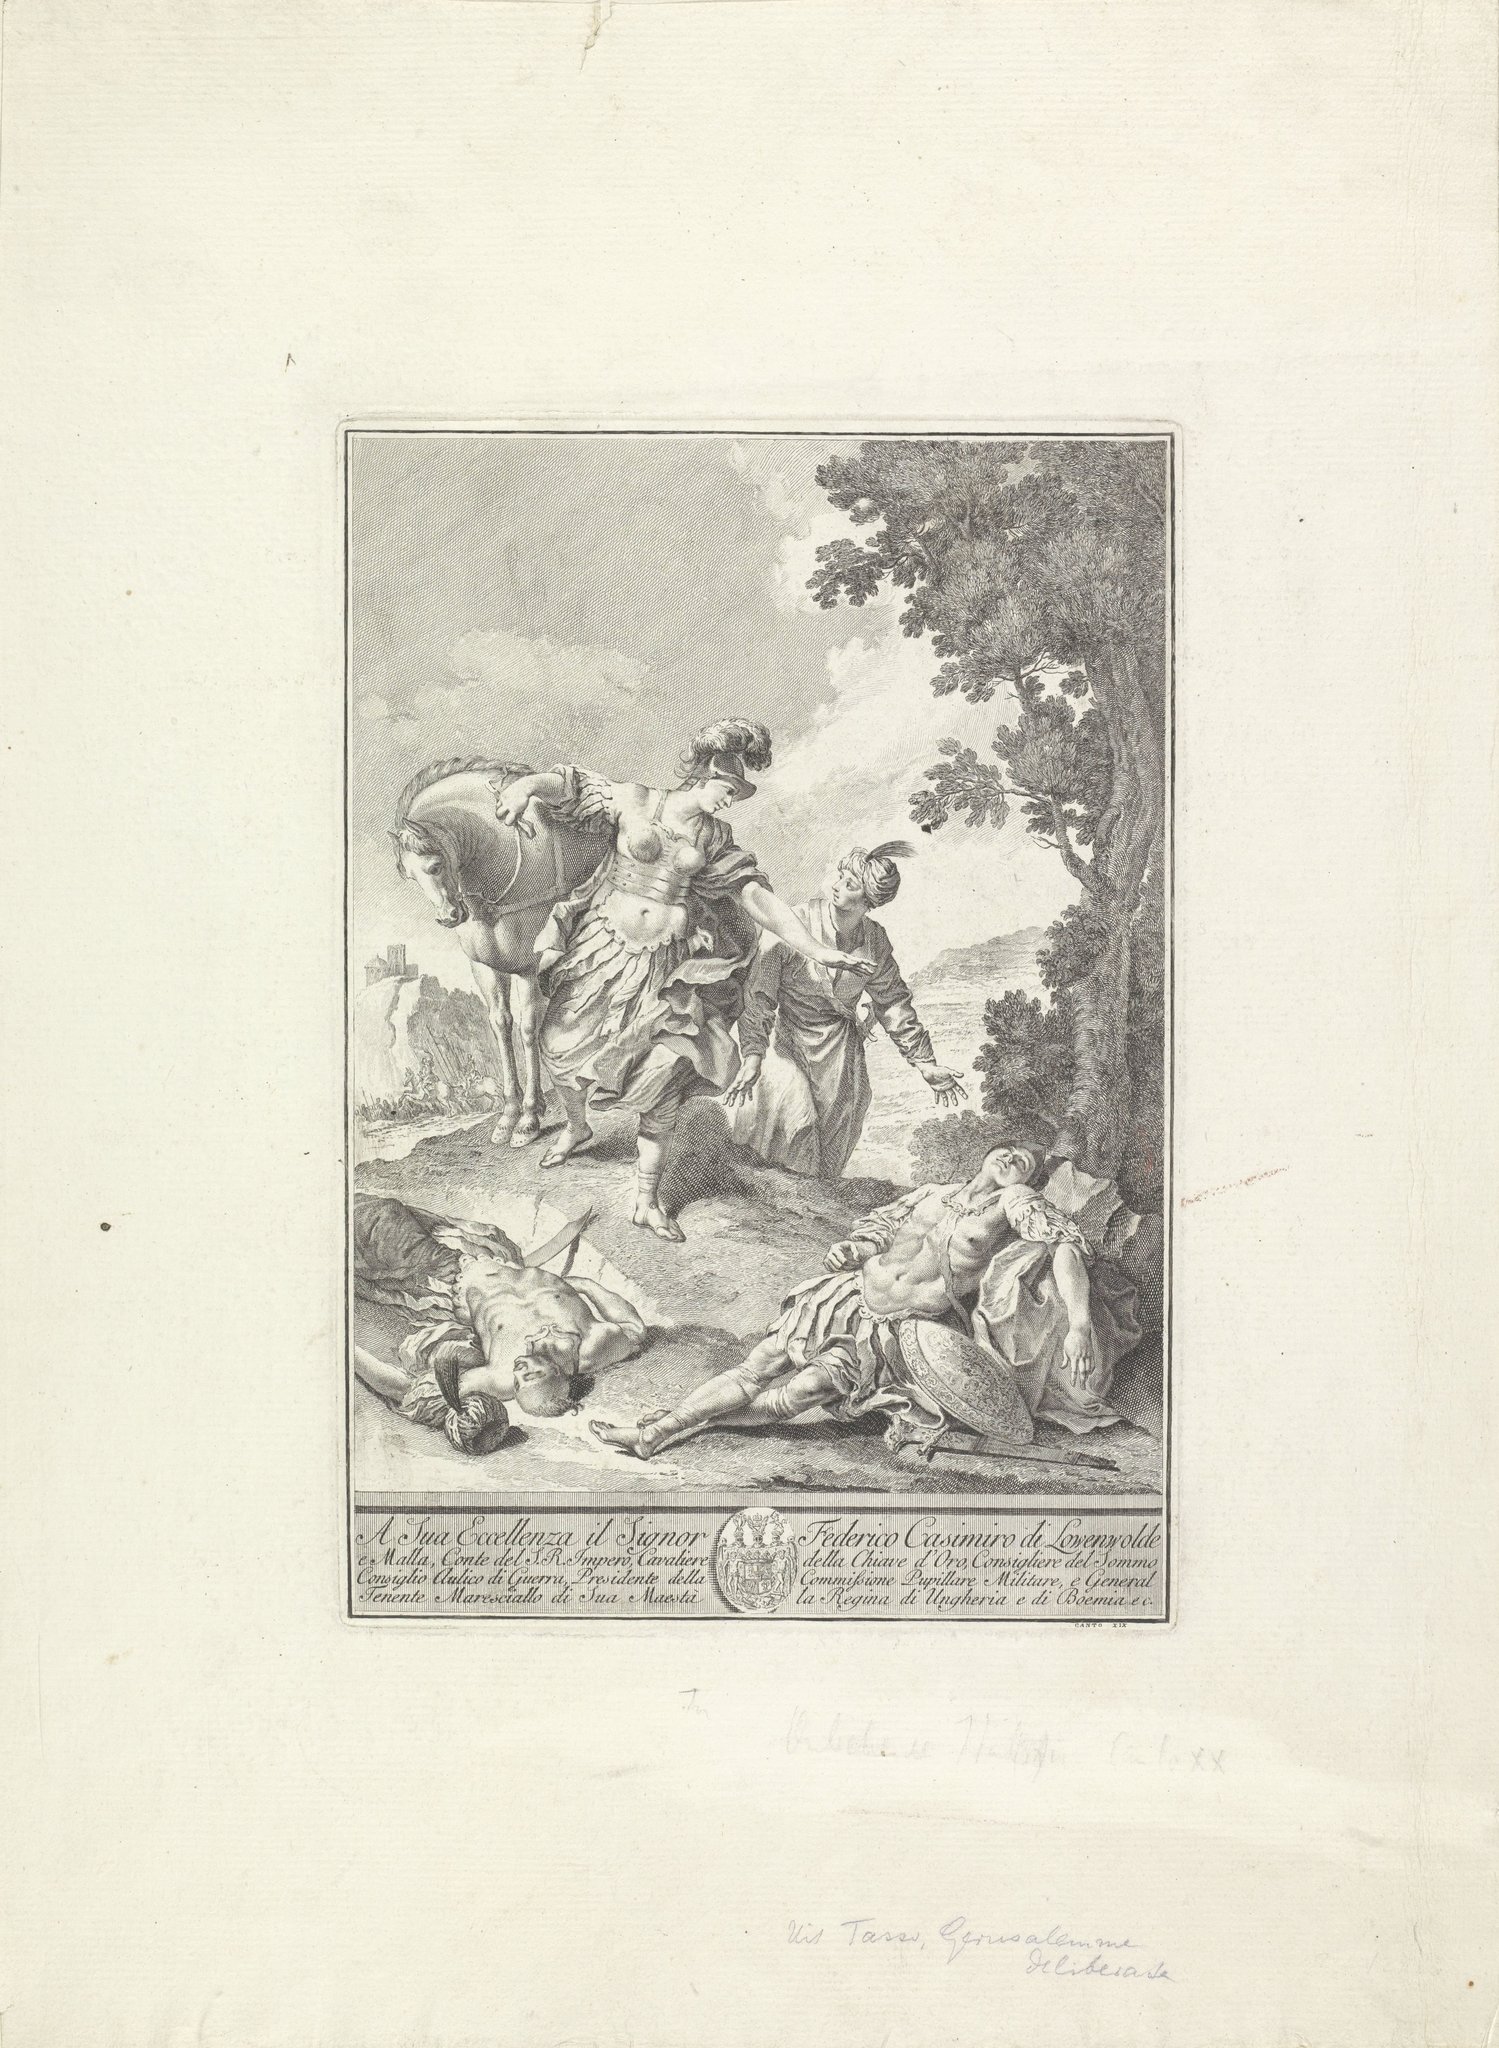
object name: print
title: Scène uit Tasso's 'La Gerusalemme liberata'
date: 1735-1800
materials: paper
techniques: engraving, etching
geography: italy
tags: torquato tasso, head-gear: turban, the corpse, horse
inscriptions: collector's mark: Lugt 240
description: Een scène uit Tasso's 'La Gerusalemme liberata'. Een vrouwenfiguur met een helm en een figuur met een tulband staan bij een paard. Ze vinden twee dode lichamen in een landschap. Tekst en wapenschild in ondermarge.